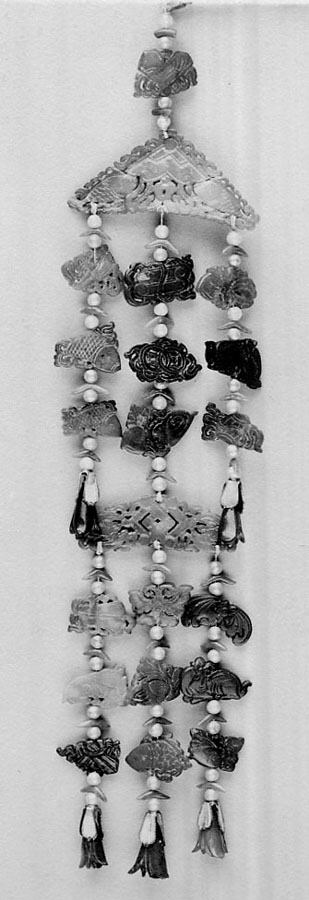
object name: headdress ornament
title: Ornament for a Headdress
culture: chinese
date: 1701-1800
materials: amber, coral, pearl